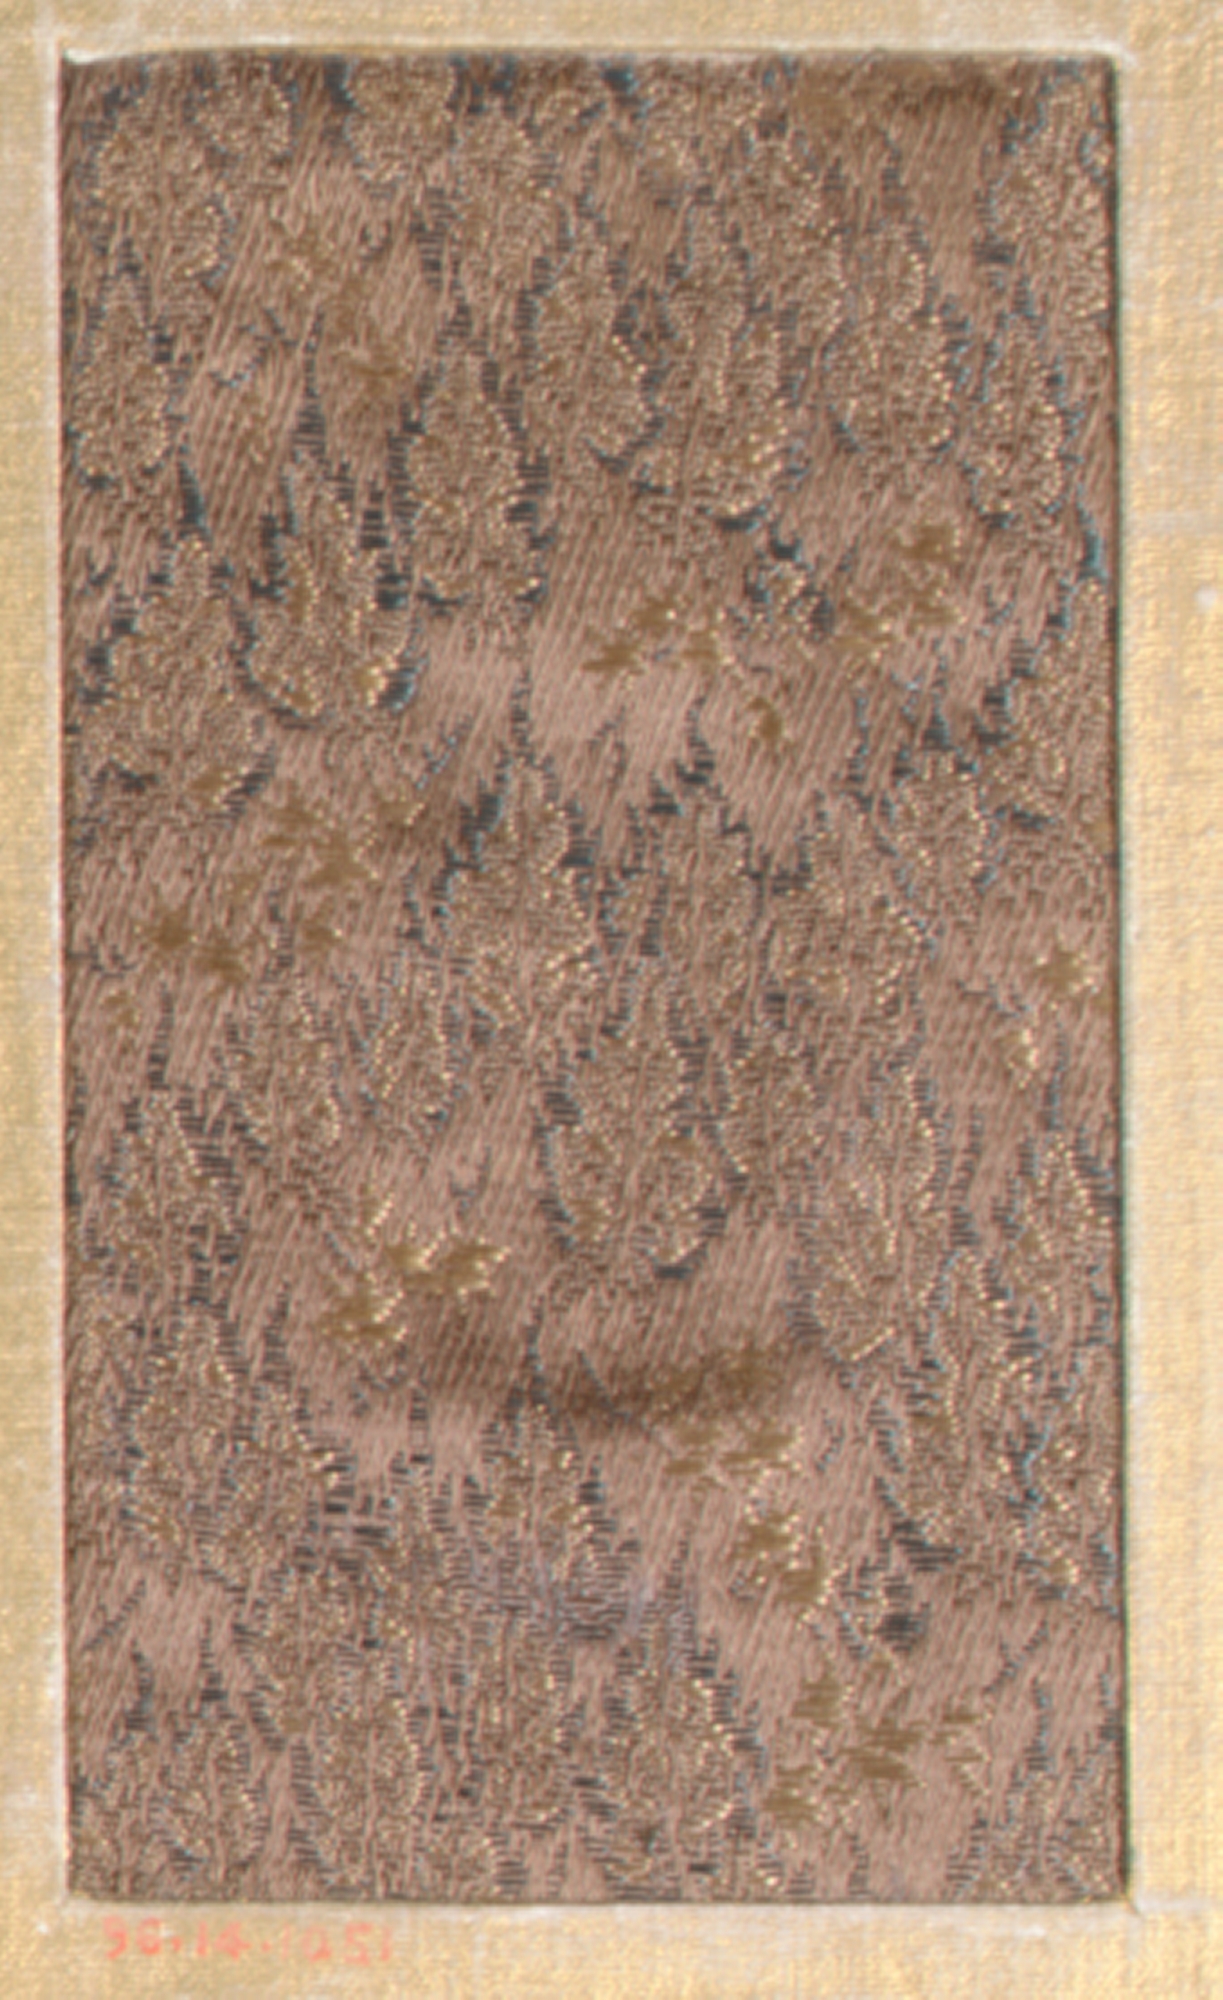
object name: piece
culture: japanese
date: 1701-1900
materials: silk